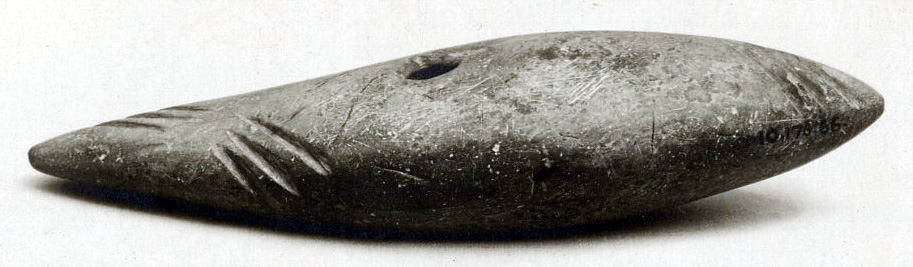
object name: mace head, lenticular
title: Lenticular macehead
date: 3850-2960 BCE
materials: limestone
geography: egypt